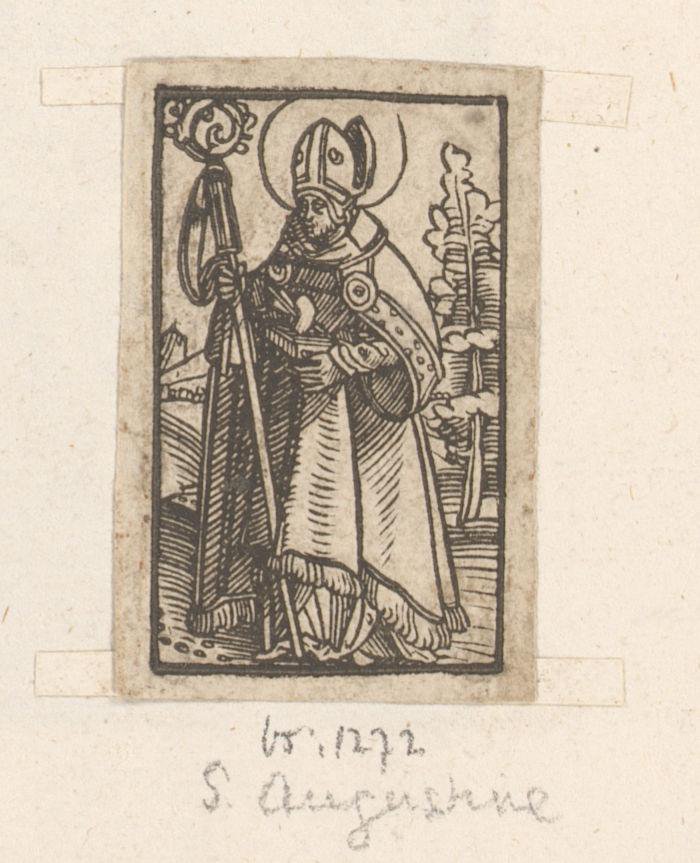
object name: album leaf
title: Heiligen en de twaalf apostelen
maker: Anonymous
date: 1500-1550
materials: paper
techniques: woodcut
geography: germany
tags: augustine, bishop of hippo; possible attributes: arrows piercing his breast, book, child with spoon, flaming heart, heart (pierced with arrows), pen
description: De kerkvader Augustinus gekleed als bisschop. Hij houdt een boek vast met daarop een met pijl doorboord hart. Prent maakt deel uit van een album.